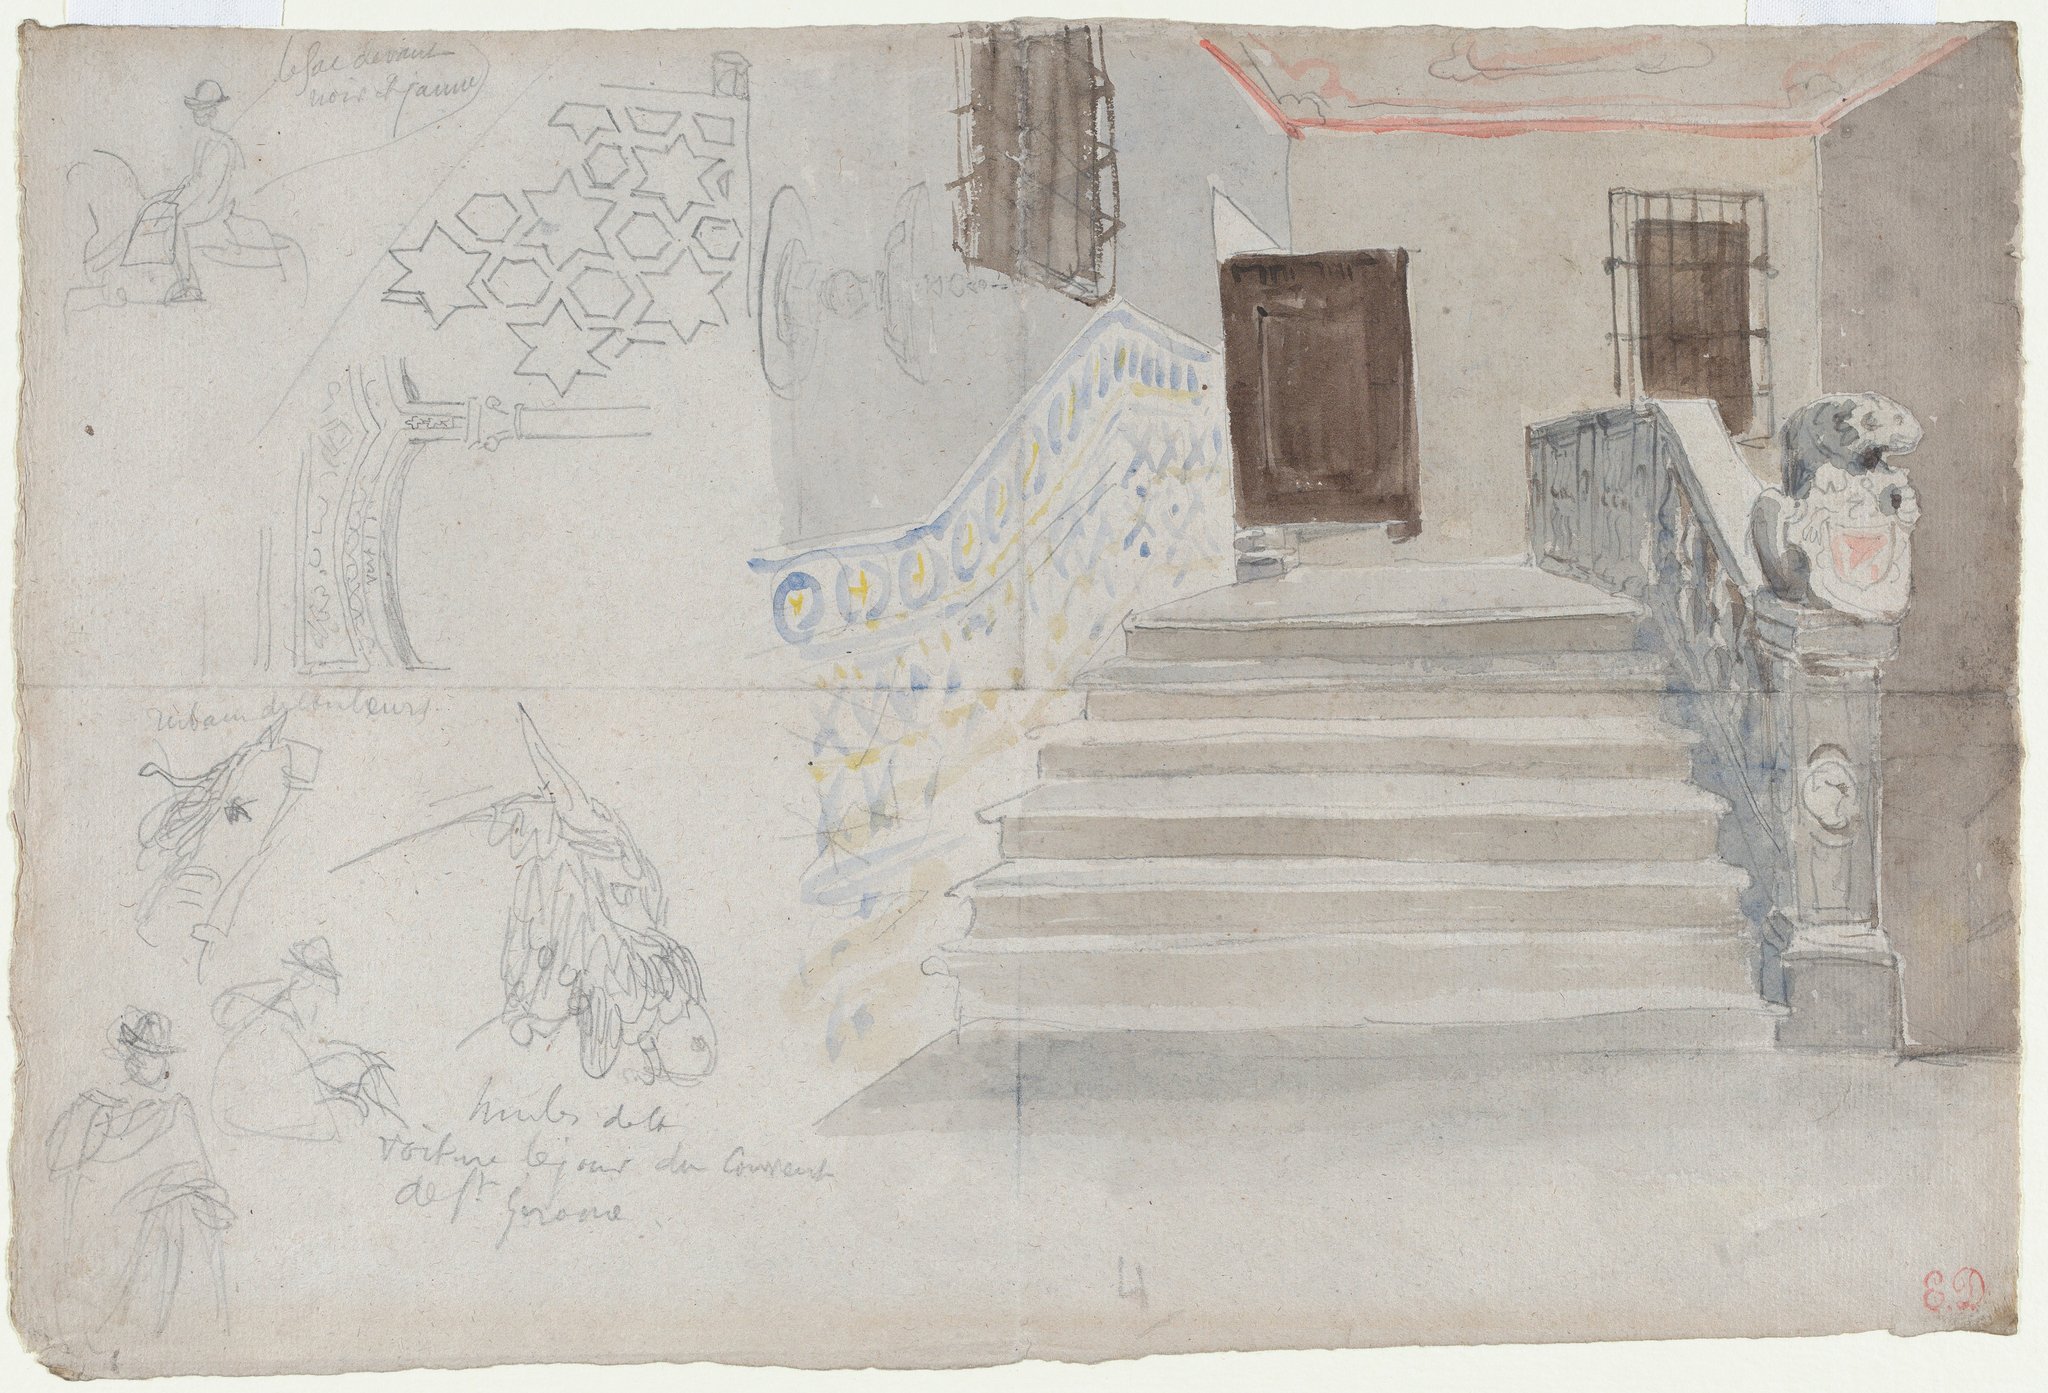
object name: drawing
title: A Staircase in Seville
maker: eugène delacroix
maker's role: artist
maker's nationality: french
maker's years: 1798-1863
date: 1832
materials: graphite, watercolor